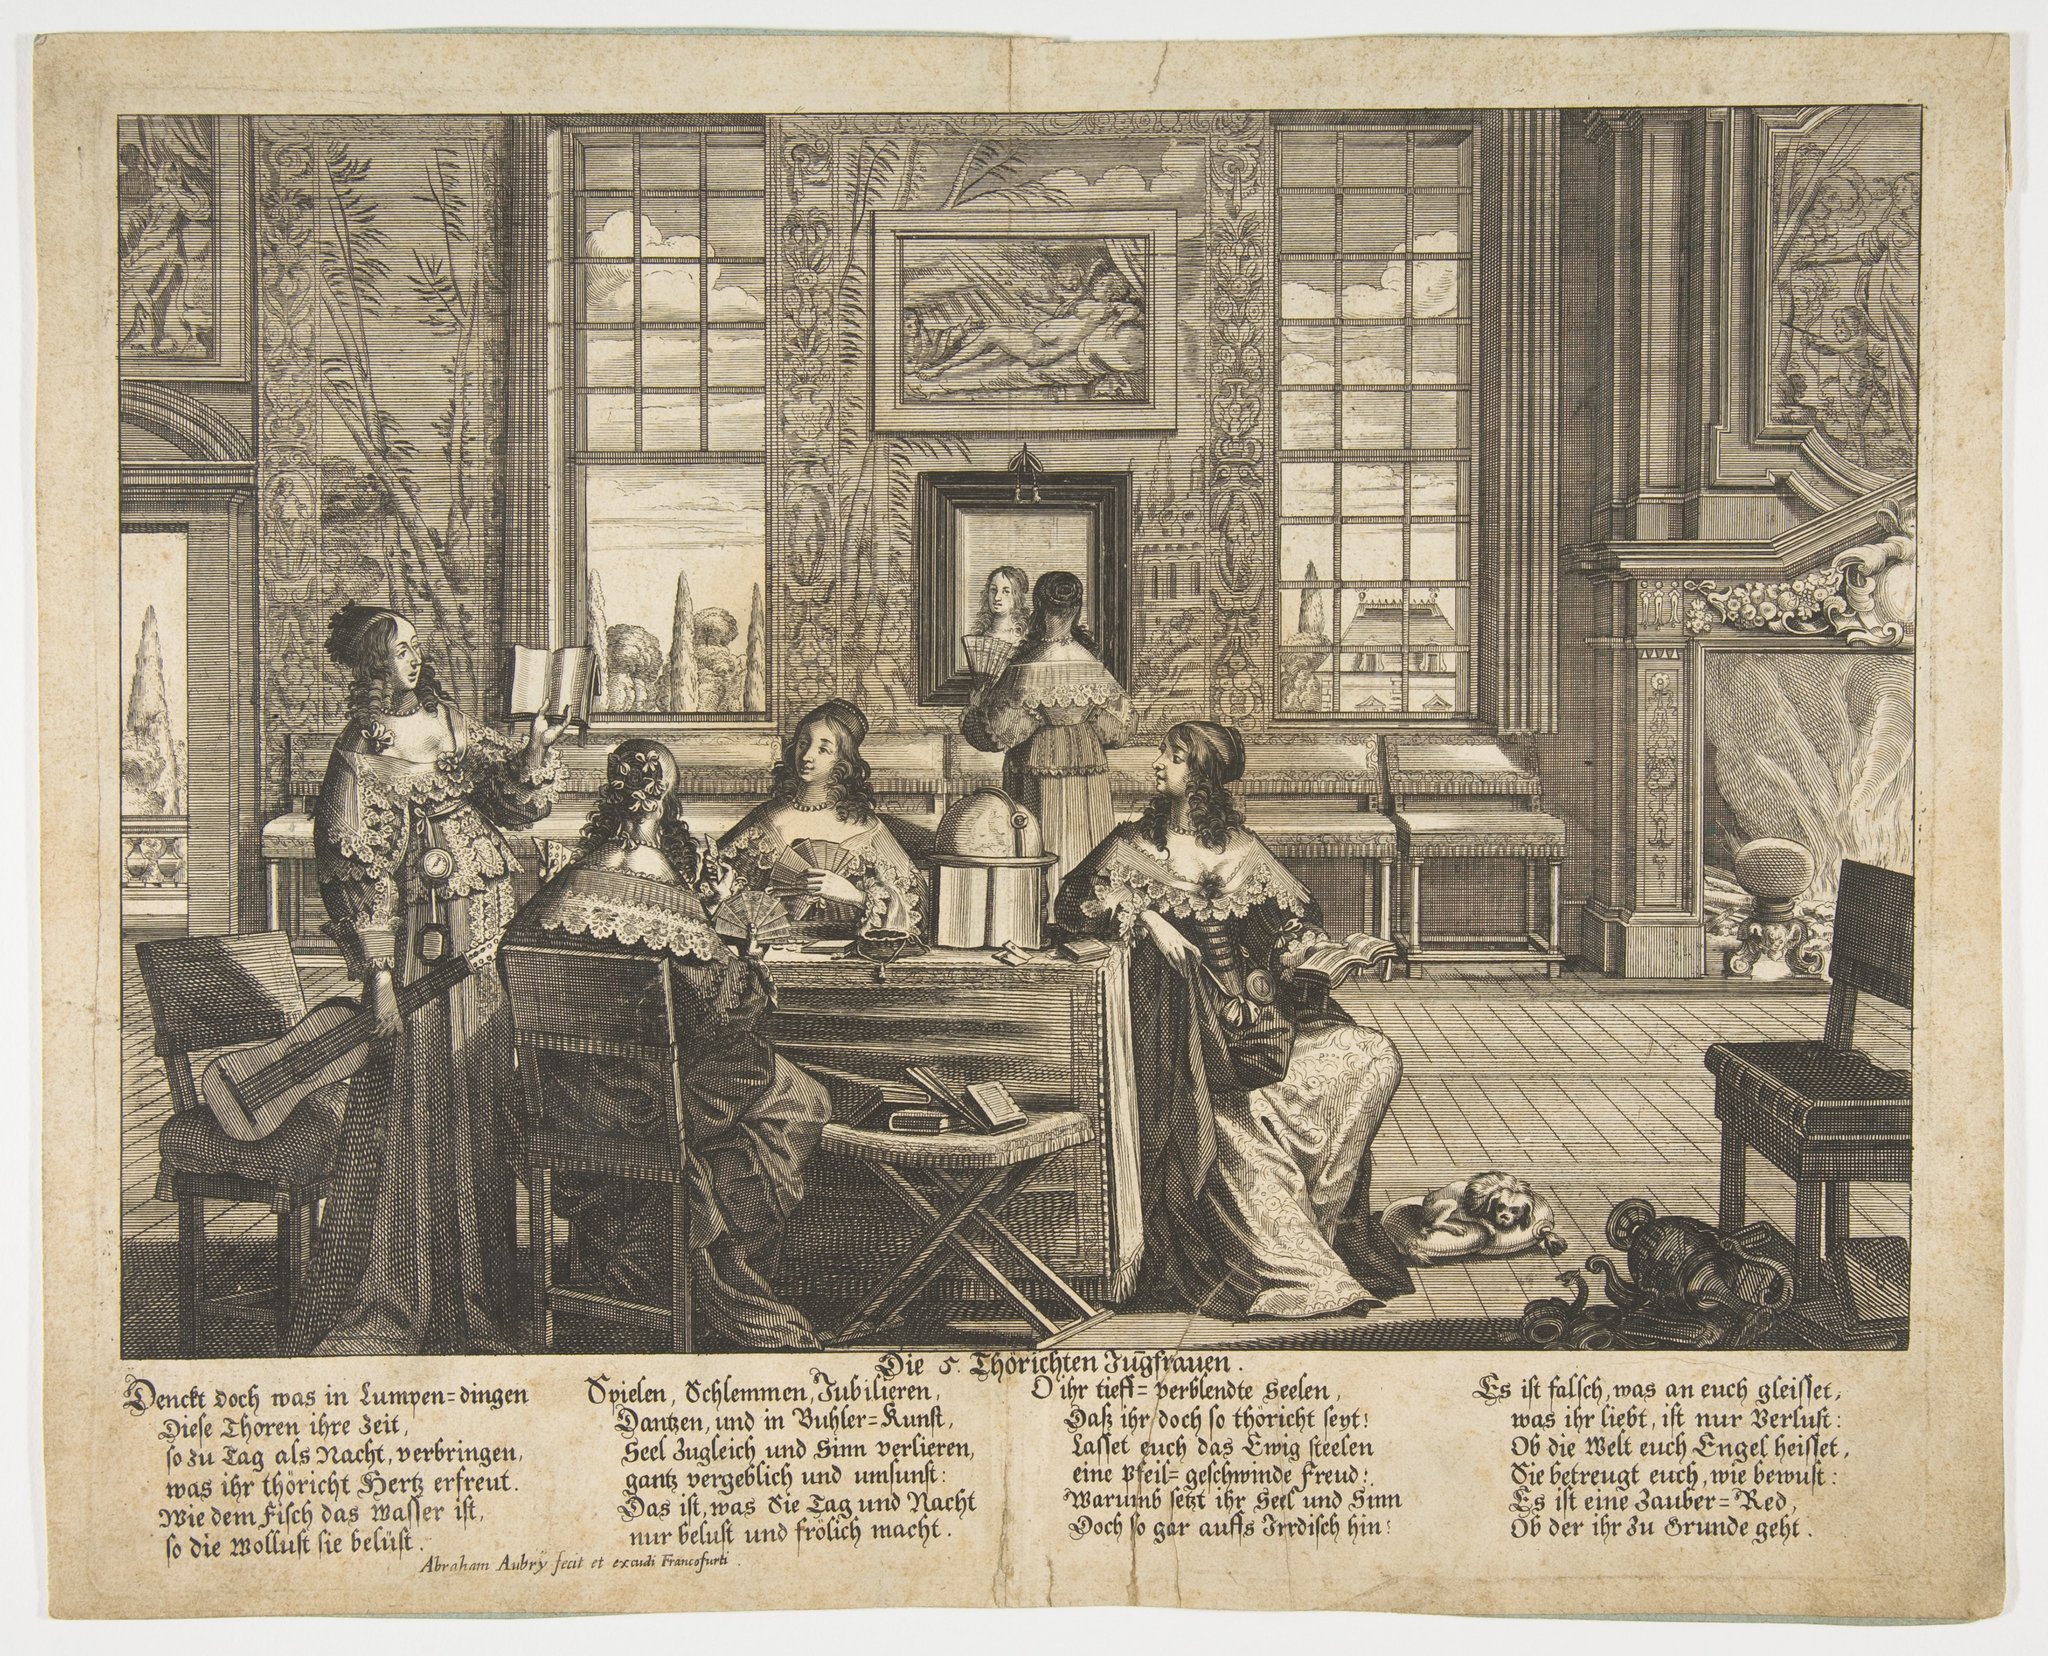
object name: print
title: The Foolish Virgins Conversing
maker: abraham aubry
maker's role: artist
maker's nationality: french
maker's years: -1682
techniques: engraving, etching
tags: musical instruments,women,playing cards